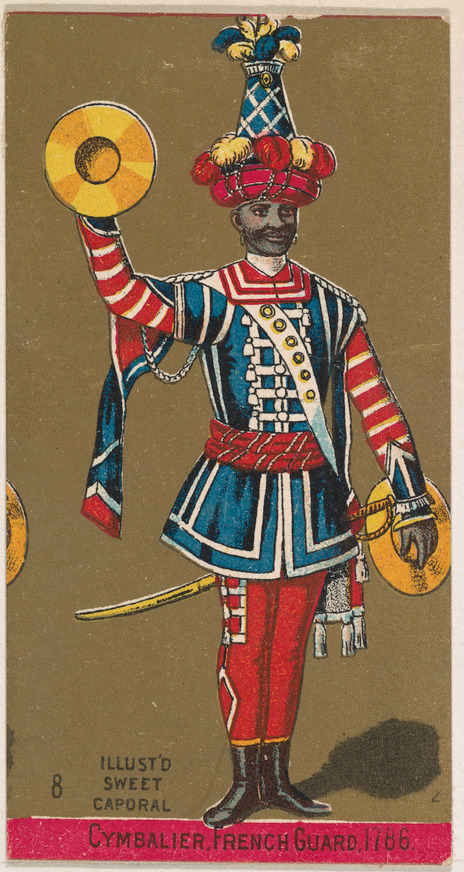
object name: print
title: Cymbalier, French Guard, 1786, from the Military Series (N224) issued by Kinney Tobacco Company to promote Sweet Caporal Cigarettes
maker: kinney brothers tobacco company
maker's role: publisher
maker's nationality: american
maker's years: 1869-2011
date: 1888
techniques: color lithograph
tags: musical instruments,military,men